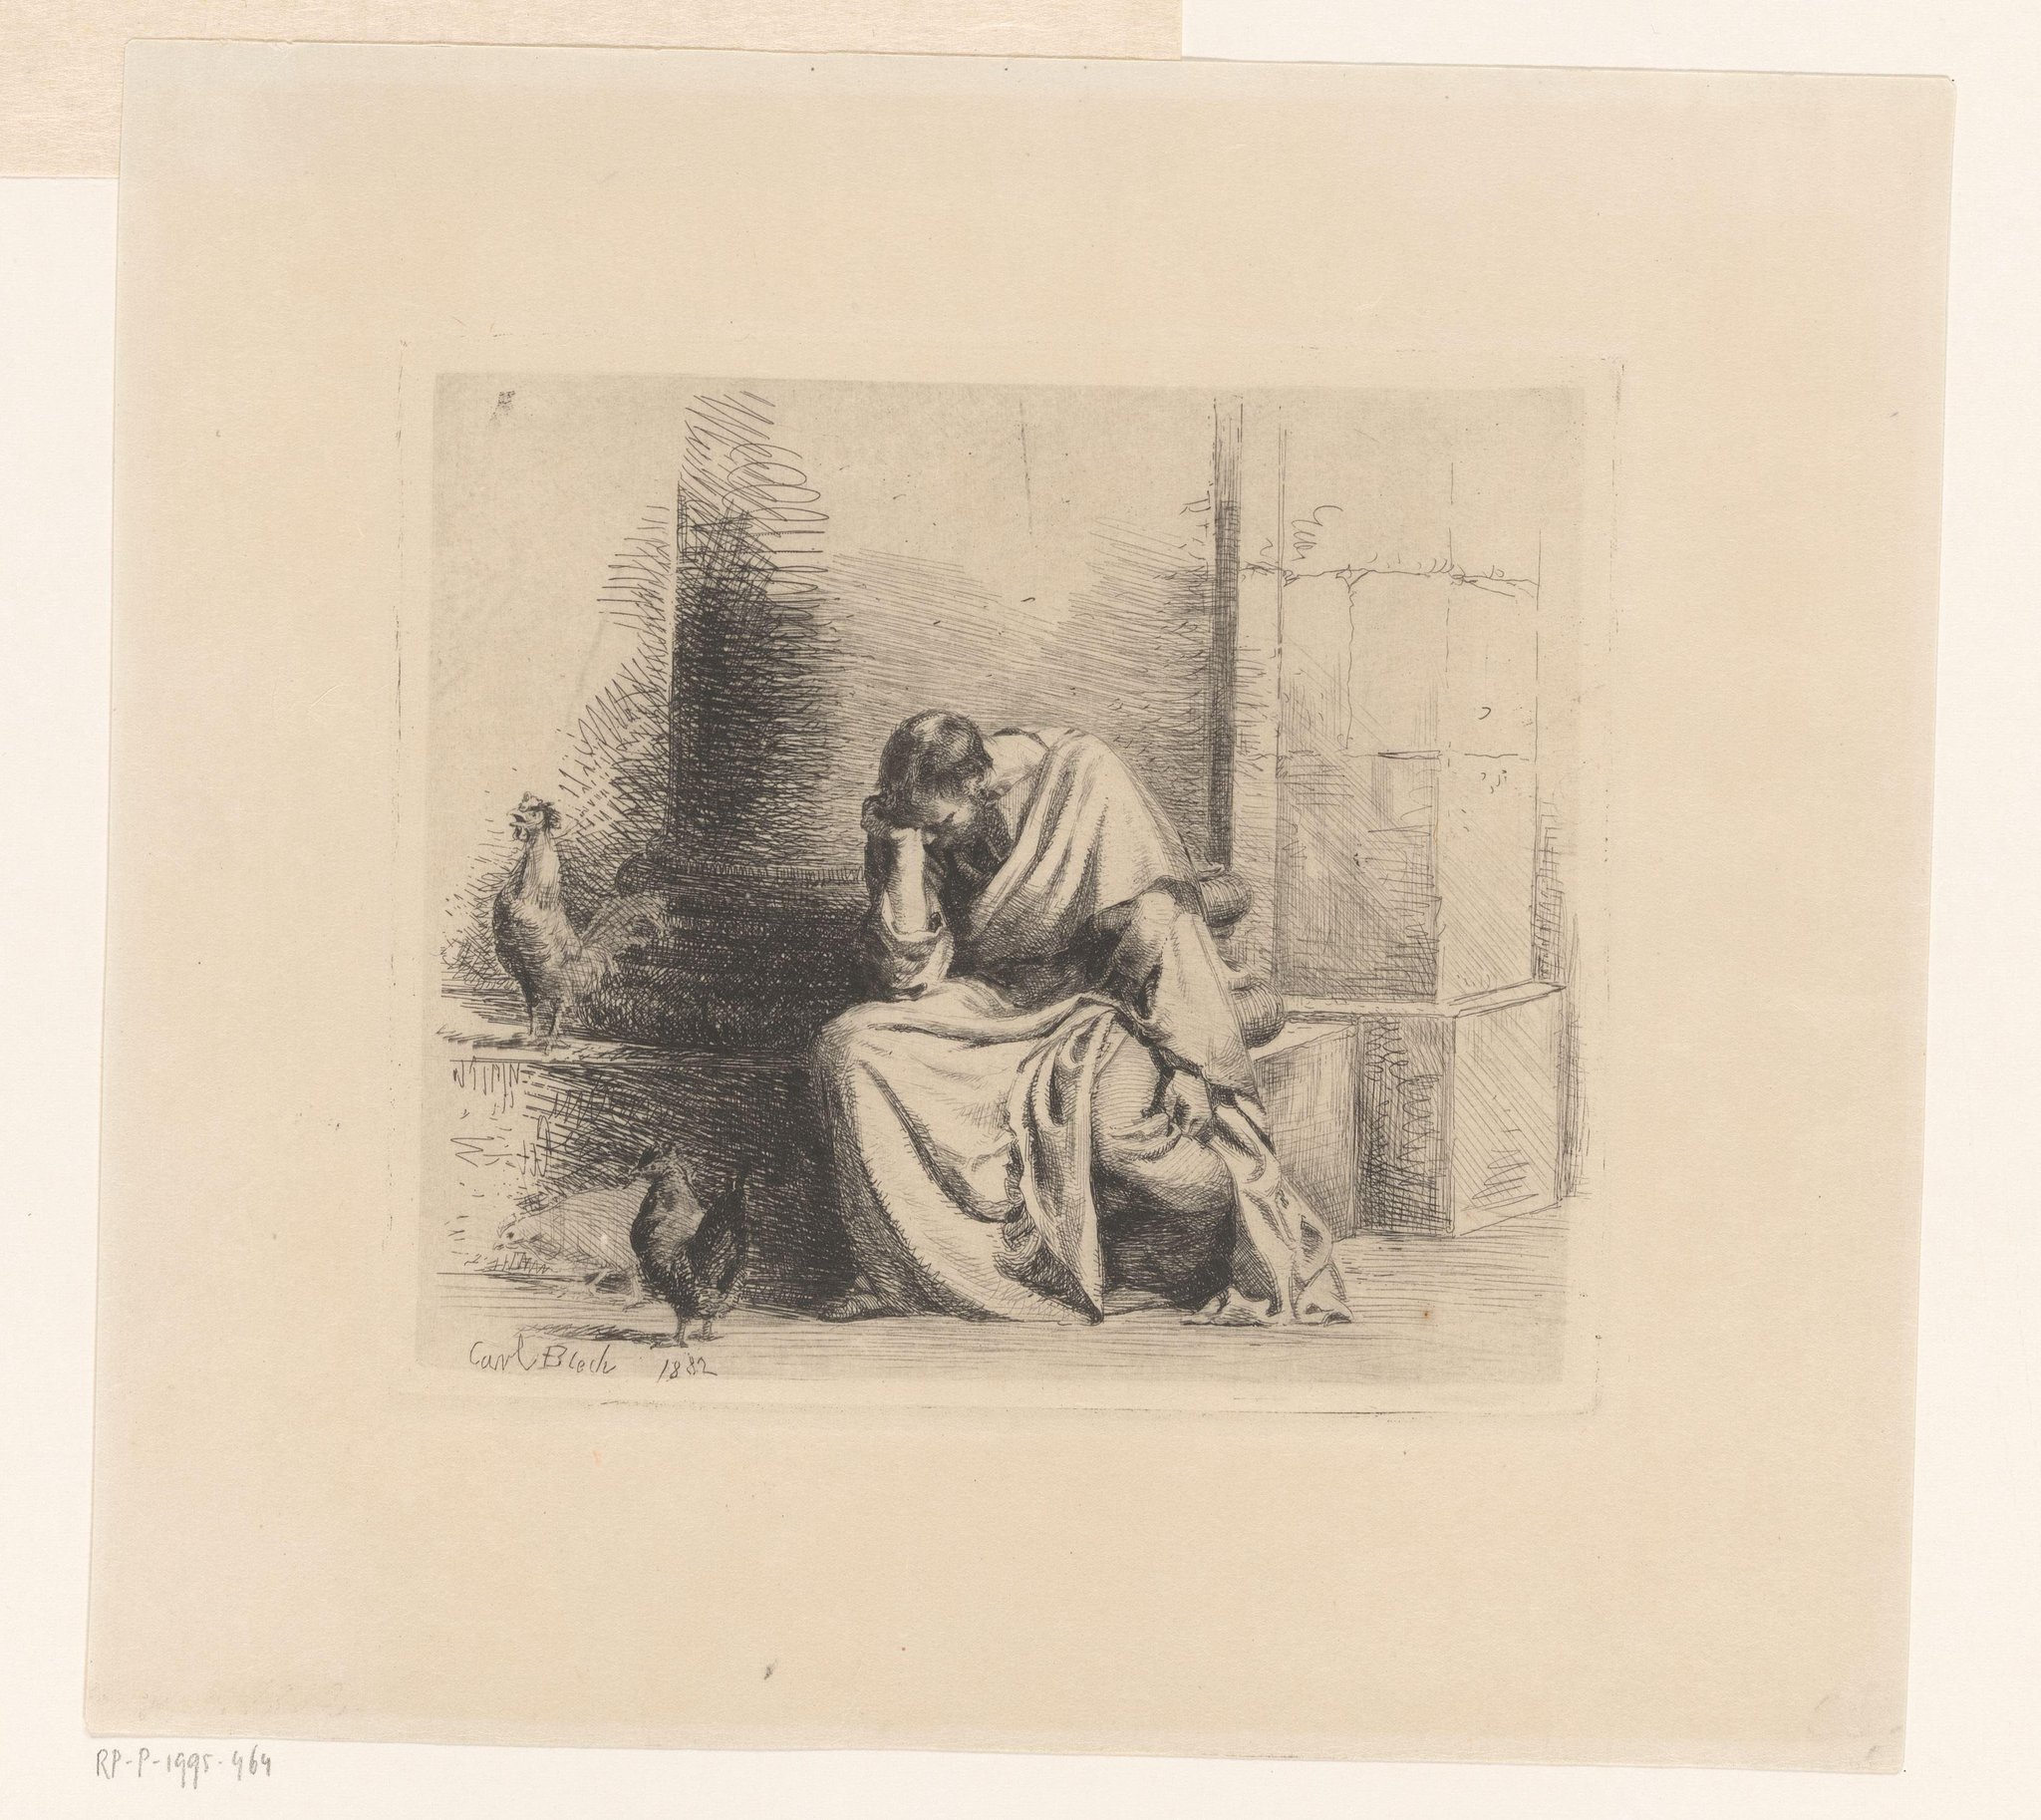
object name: print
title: Petrus met kraaiende haan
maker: carl bloch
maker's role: print maker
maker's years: 1834-1890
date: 1882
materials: paper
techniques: drypoint, etching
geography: scandinavia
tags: the crowing cock ~ denial of peter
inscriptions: collector's mark: Lugt 2228, signature and date: ‘l.o. gesigneerd en gedateerd Carl Bloch 1882’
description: Petrus, in gebogen houding zittend op de sokkel van een zuil, zijn hand steunt het gebogen hoofd. Naast hem een kraaiende haan.